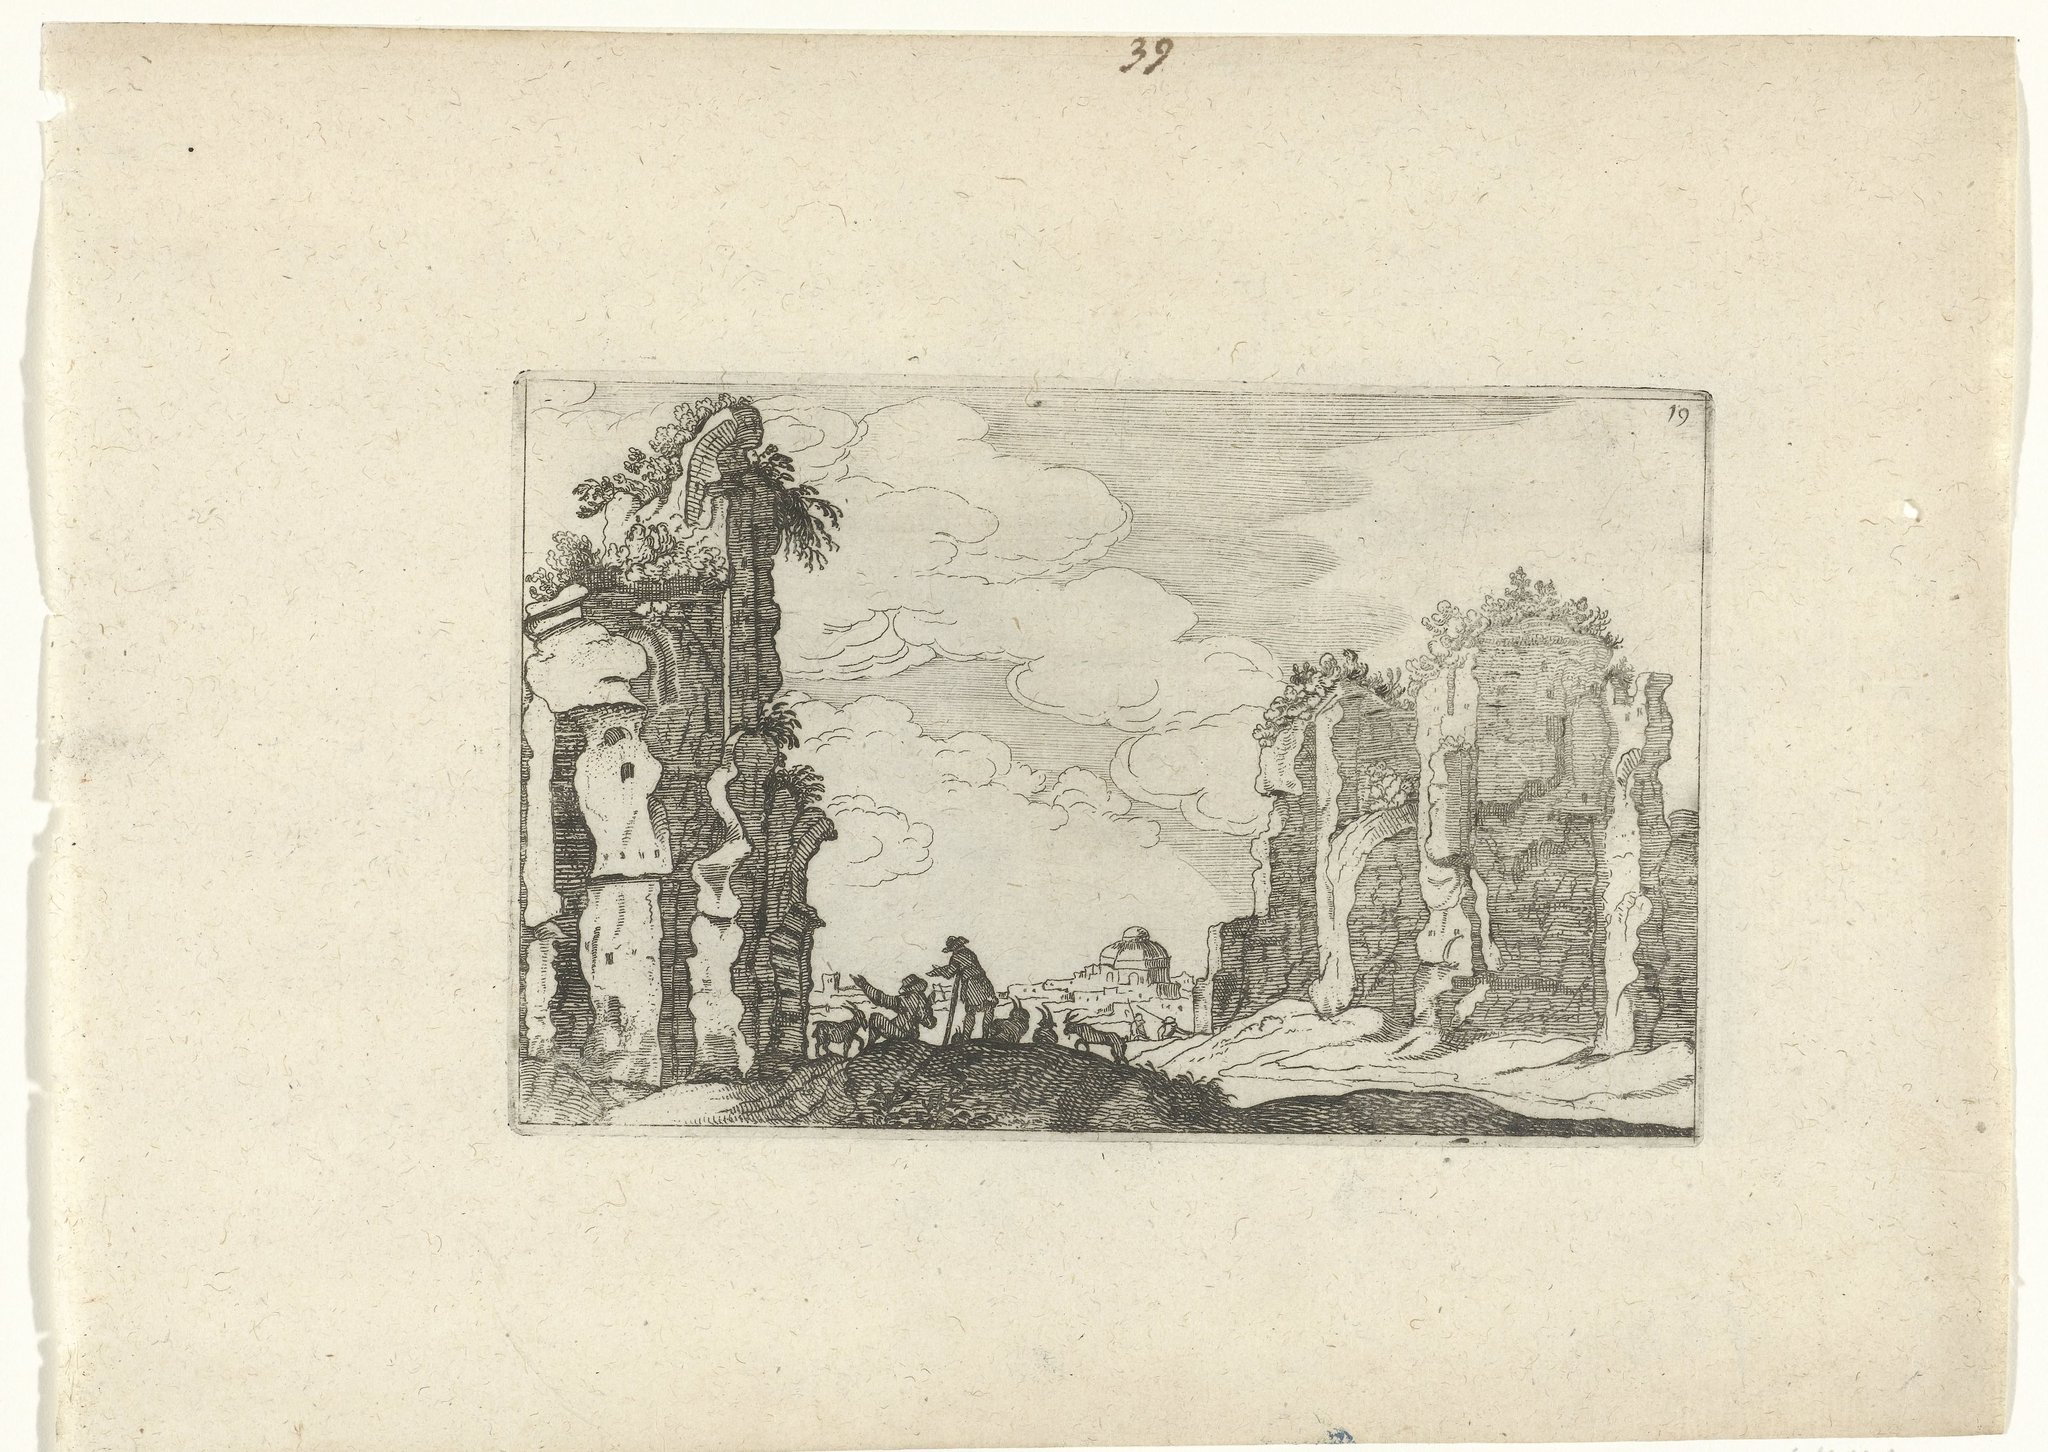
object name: print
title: Romeinse ruïnes en kustlandschappen (serie 2)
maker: Anonymous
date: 1594-1685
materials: paper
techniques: etching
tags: herding, herdsman, herdswoman, shepherd, shepherdess, cowherd, etc., landscape with ruins (+ city(-scape) with figures, staffage), rome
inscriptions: inscription: ‘39’, collector's mark: Lugt 2760, collector's mark: Lugt 2228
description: De begroeide ruïnes van de thermen van Caracalla in Rome. Op de voorgrond twee herders met een kudde geiten. Op de achtergrond de stad Rome. Prent maakt deel uit van een serie Romeinse ruïnes en kustlandschappen naar prenten van Willem van Nieulandt. Deze serie is een kopie van de serie, die Claes Jansz Visscher naar Van Nieulandt maakte.